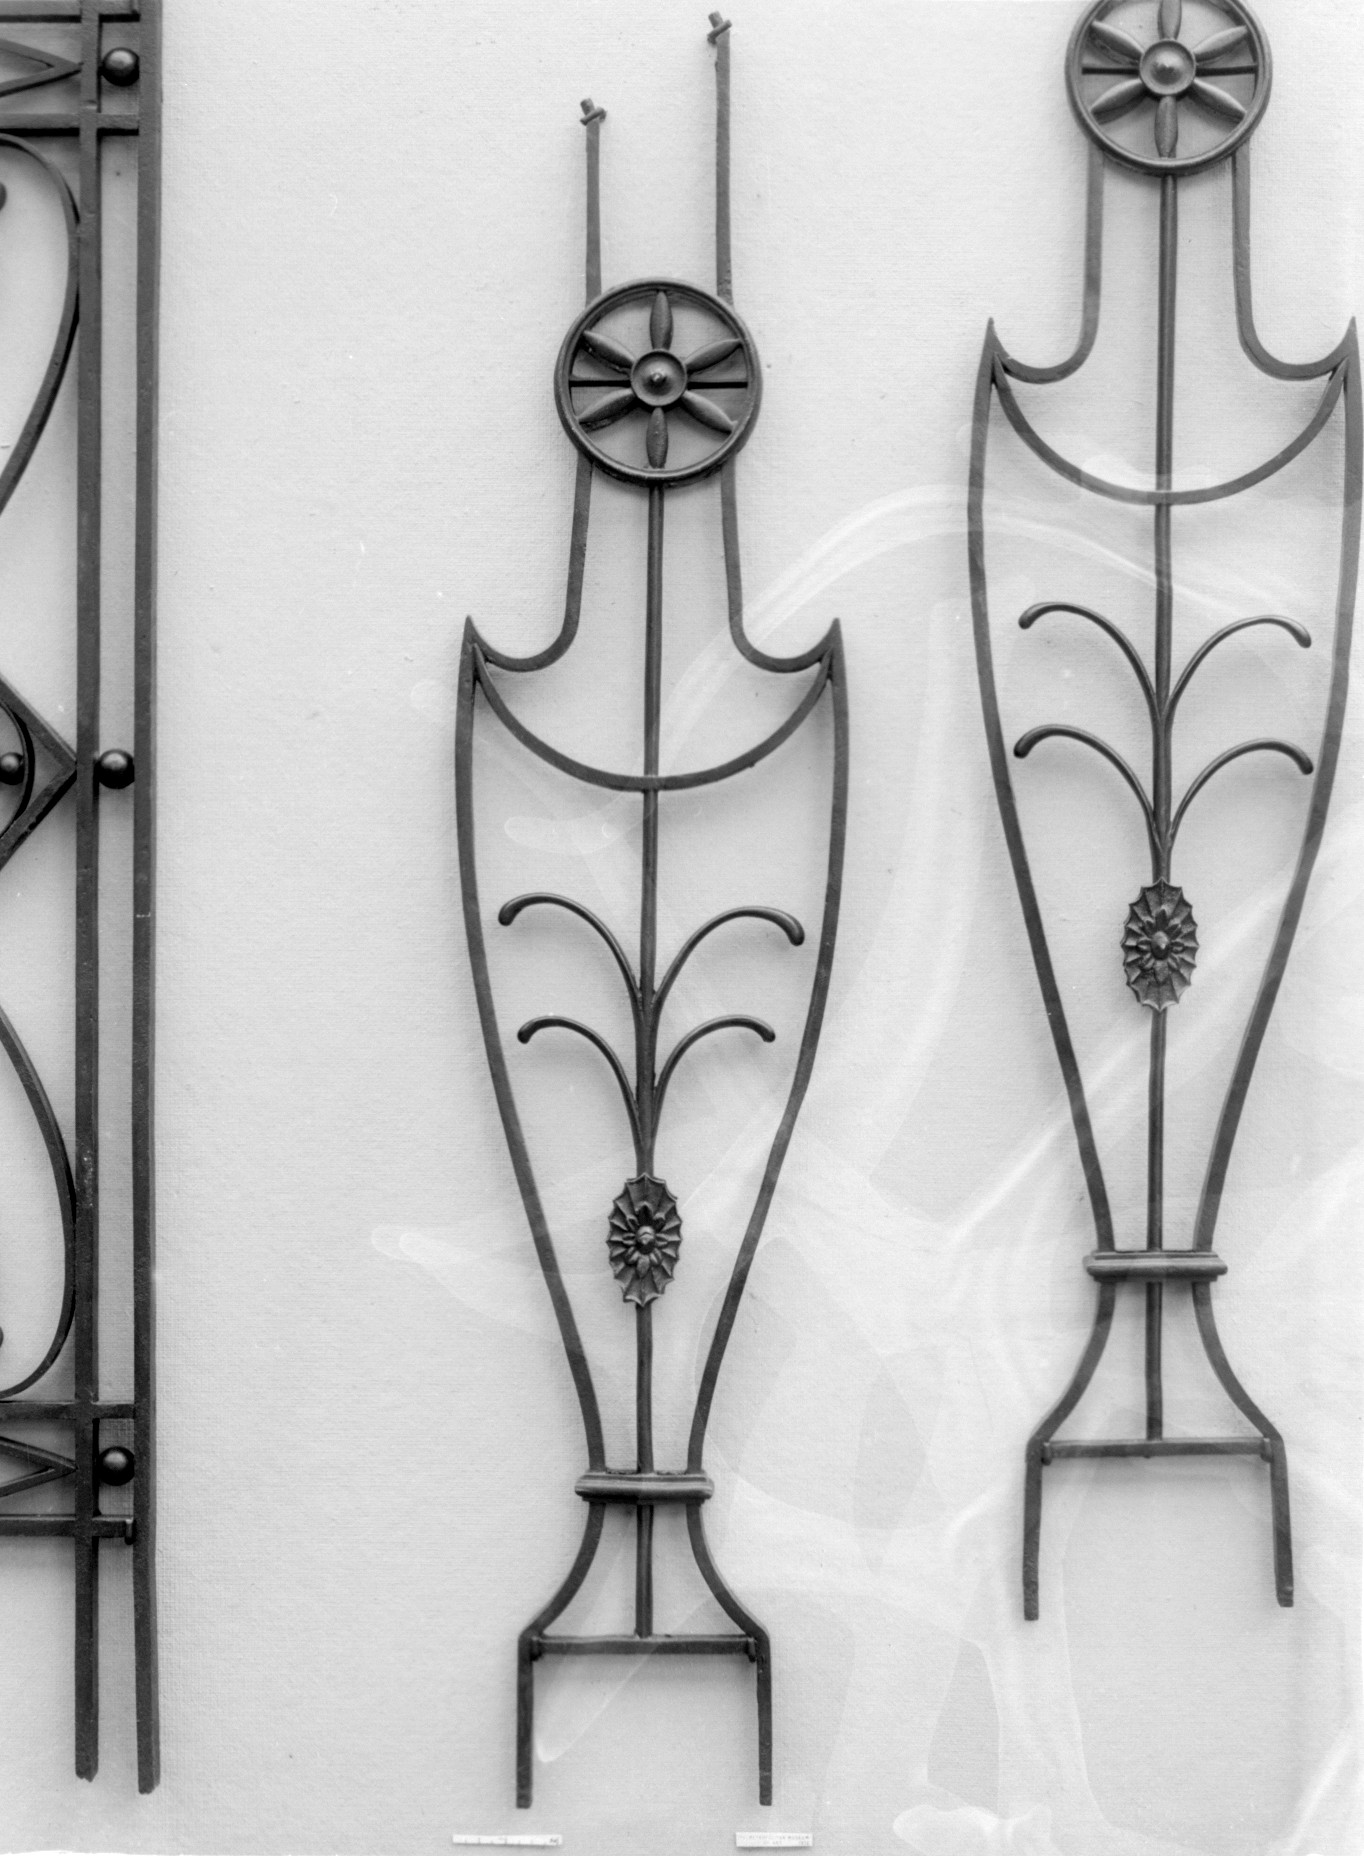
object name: baluster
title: Pair of balusters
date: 1701-1800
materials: brass, iron